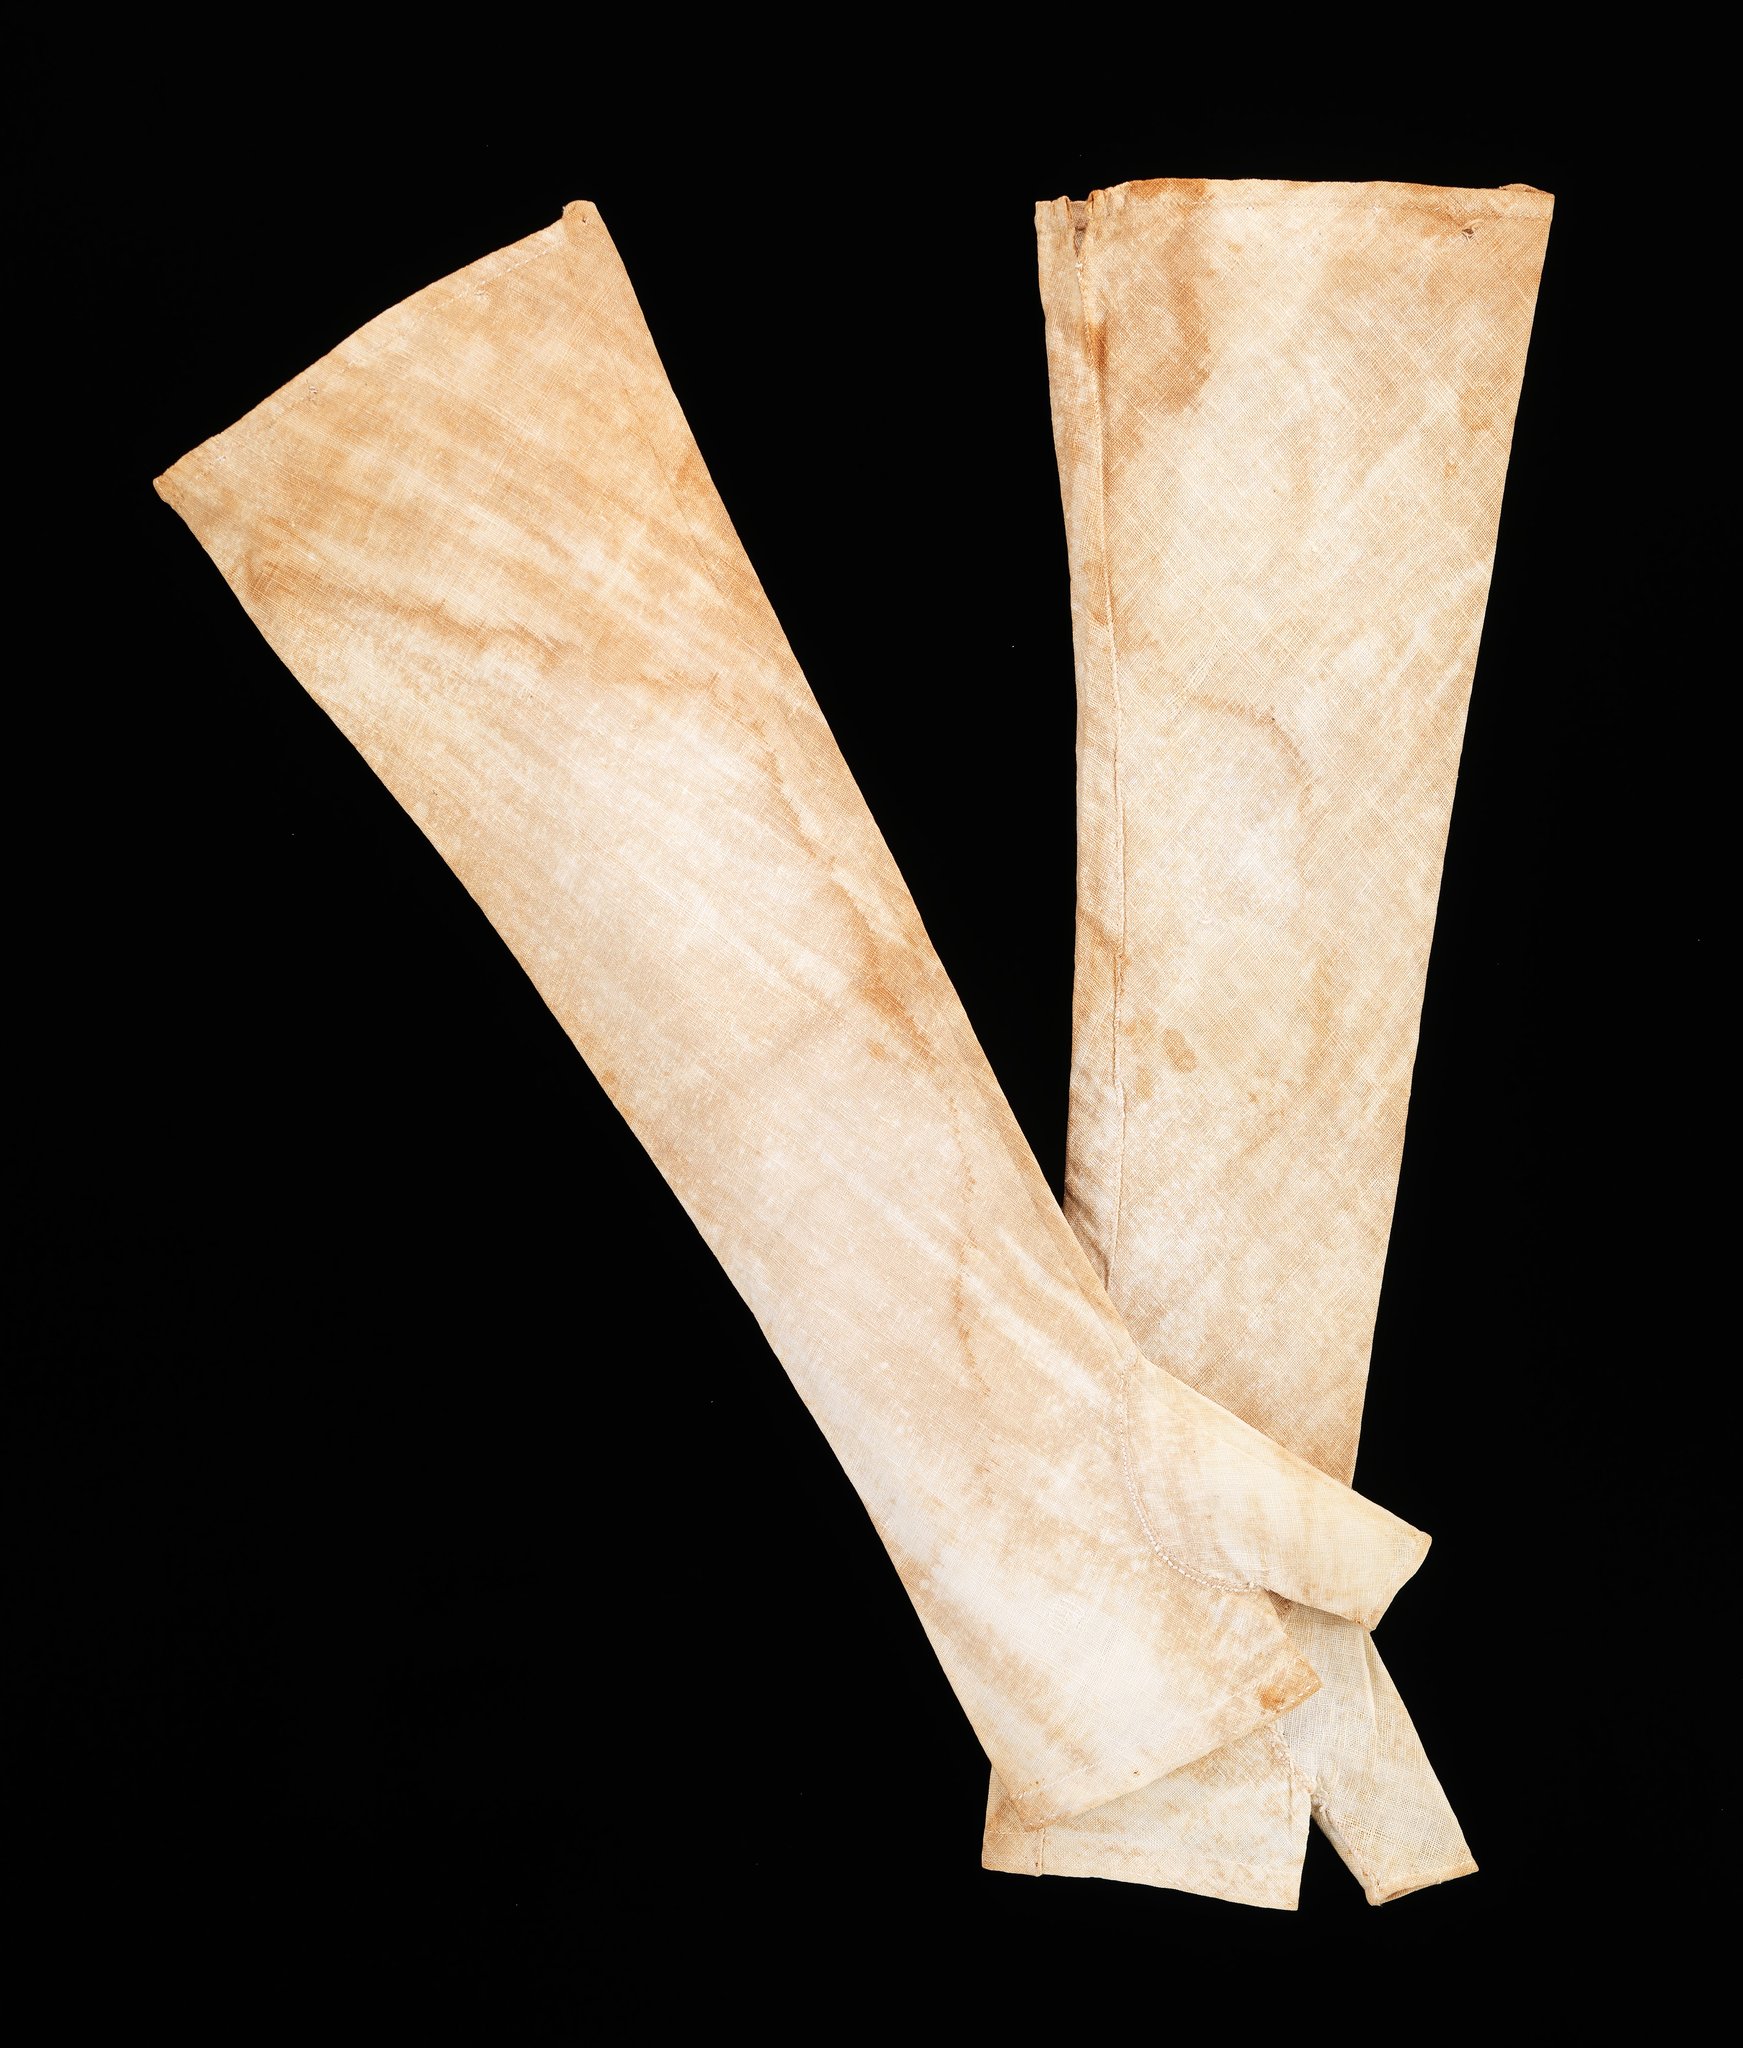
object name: mitt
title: Mitts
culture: american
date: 1800-1824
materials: linen